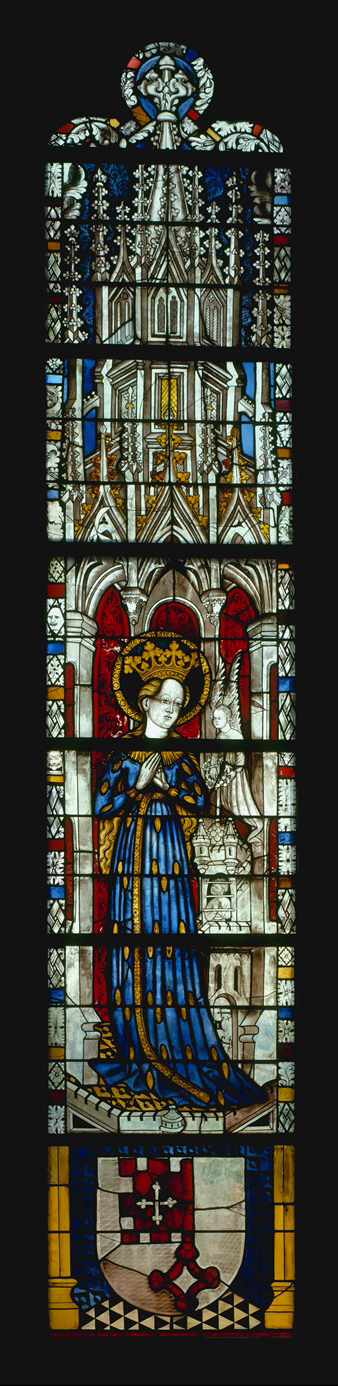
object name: panel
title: The Virgin in a Blue Robe Decorated with Images of Wheat, with the Arms of the Bishop of Liège below (from a series with The Virgin Mary and Five Standing Saints)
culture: german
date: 1440-1446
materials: glass, metal, paint, pigment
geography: germany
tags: virgin mary,saints,coat of arms